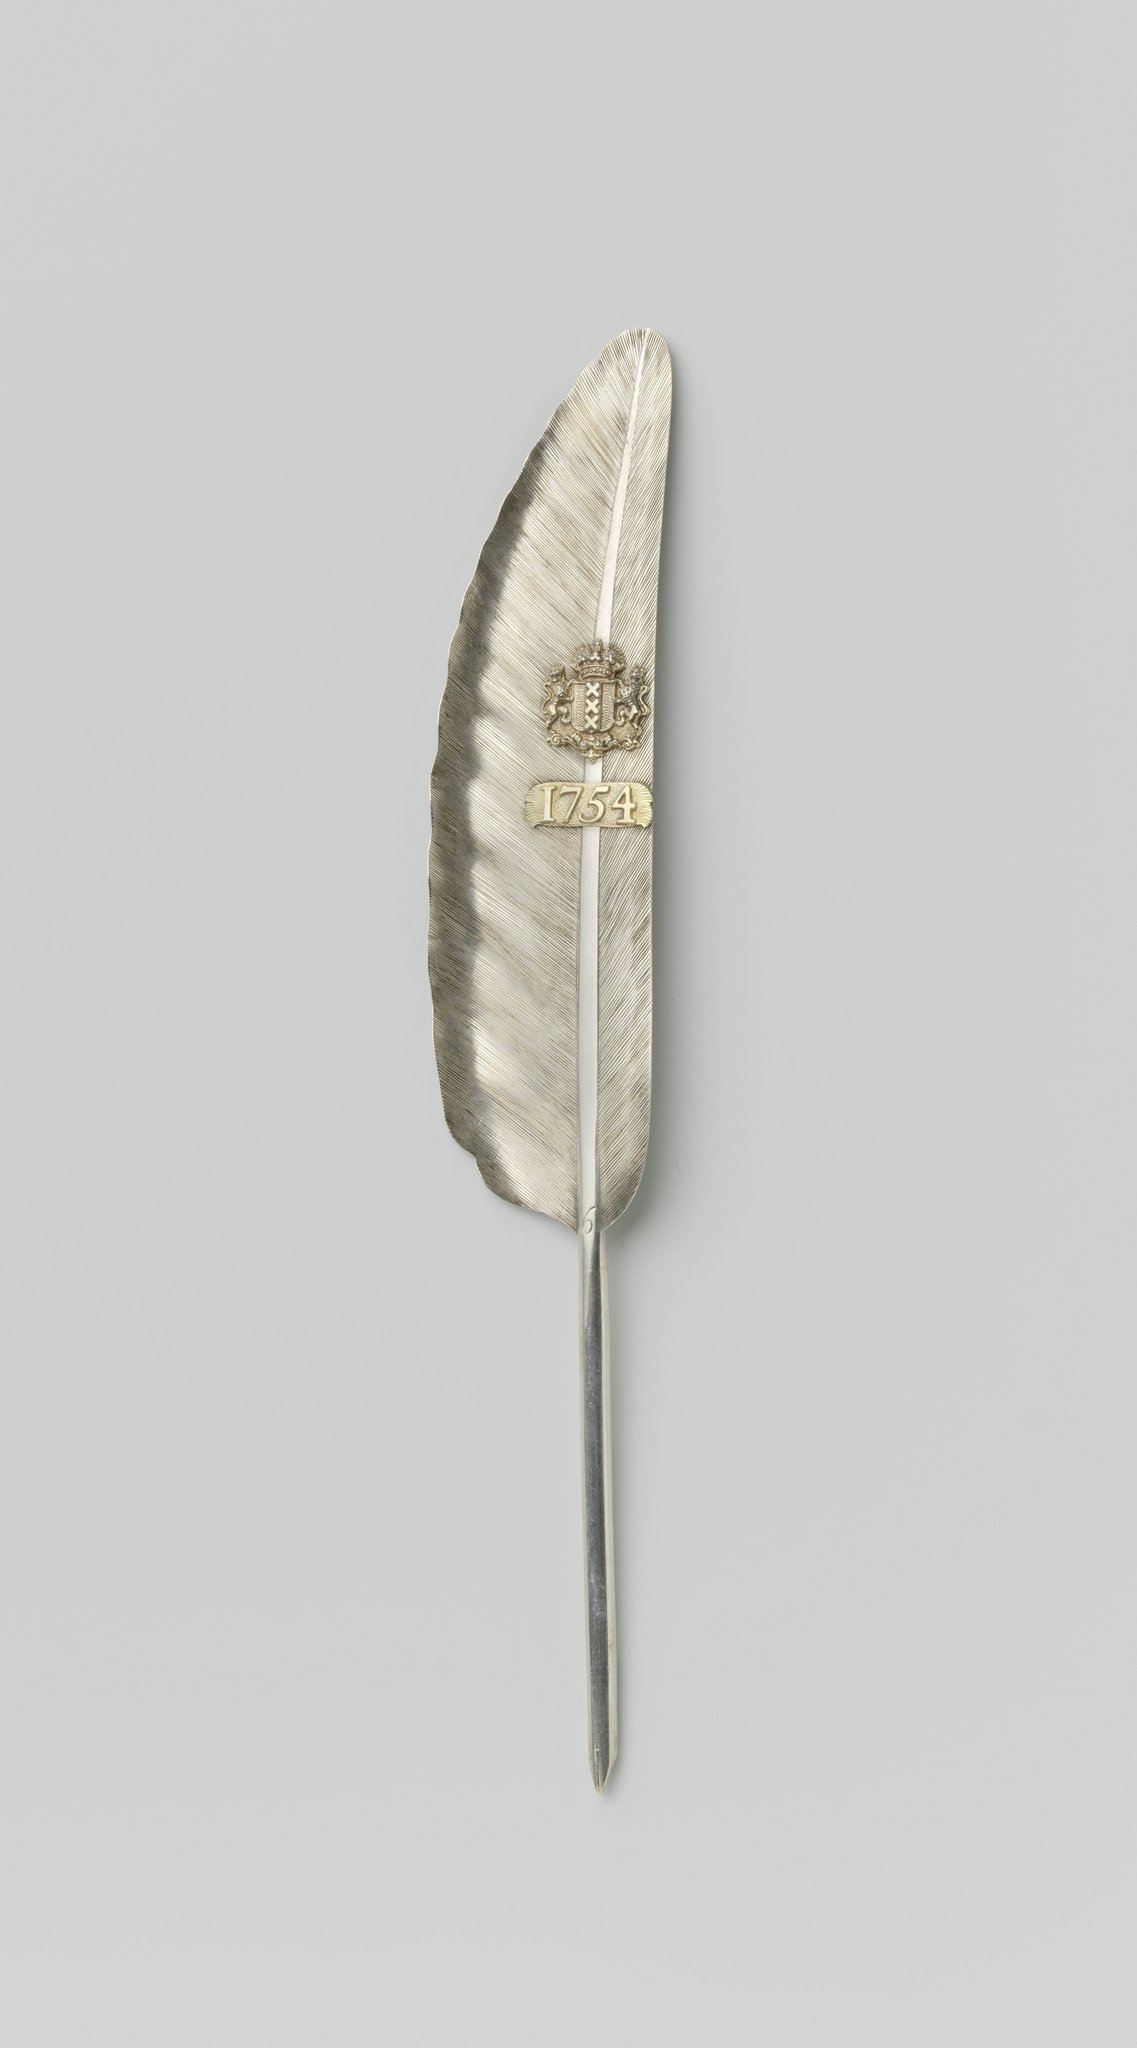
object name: prijspen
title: Prijspen met het wapen van Amsterdam en het jaartal 1754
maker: jan aernout bos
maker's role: silversmith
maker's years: 1713-1765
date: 1753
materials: silver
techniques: casting, gilding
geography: amsterdam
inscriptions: town mark, date letter: ‘T’, maker's mark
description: De pen heeft de vorm van een ganzenveer, waarop het gegoten, vergulde, gekroonde wapen van Amsterdam, gehouden door leeuwen die staan op twee bladvoluten ter weerszijden van een culot, is geappliqueerd. Daaronder is een gegoten, verguld plaatje met jaartal 1754 geappliqueerd. In de schacht is het cijfer 6 gegrift.